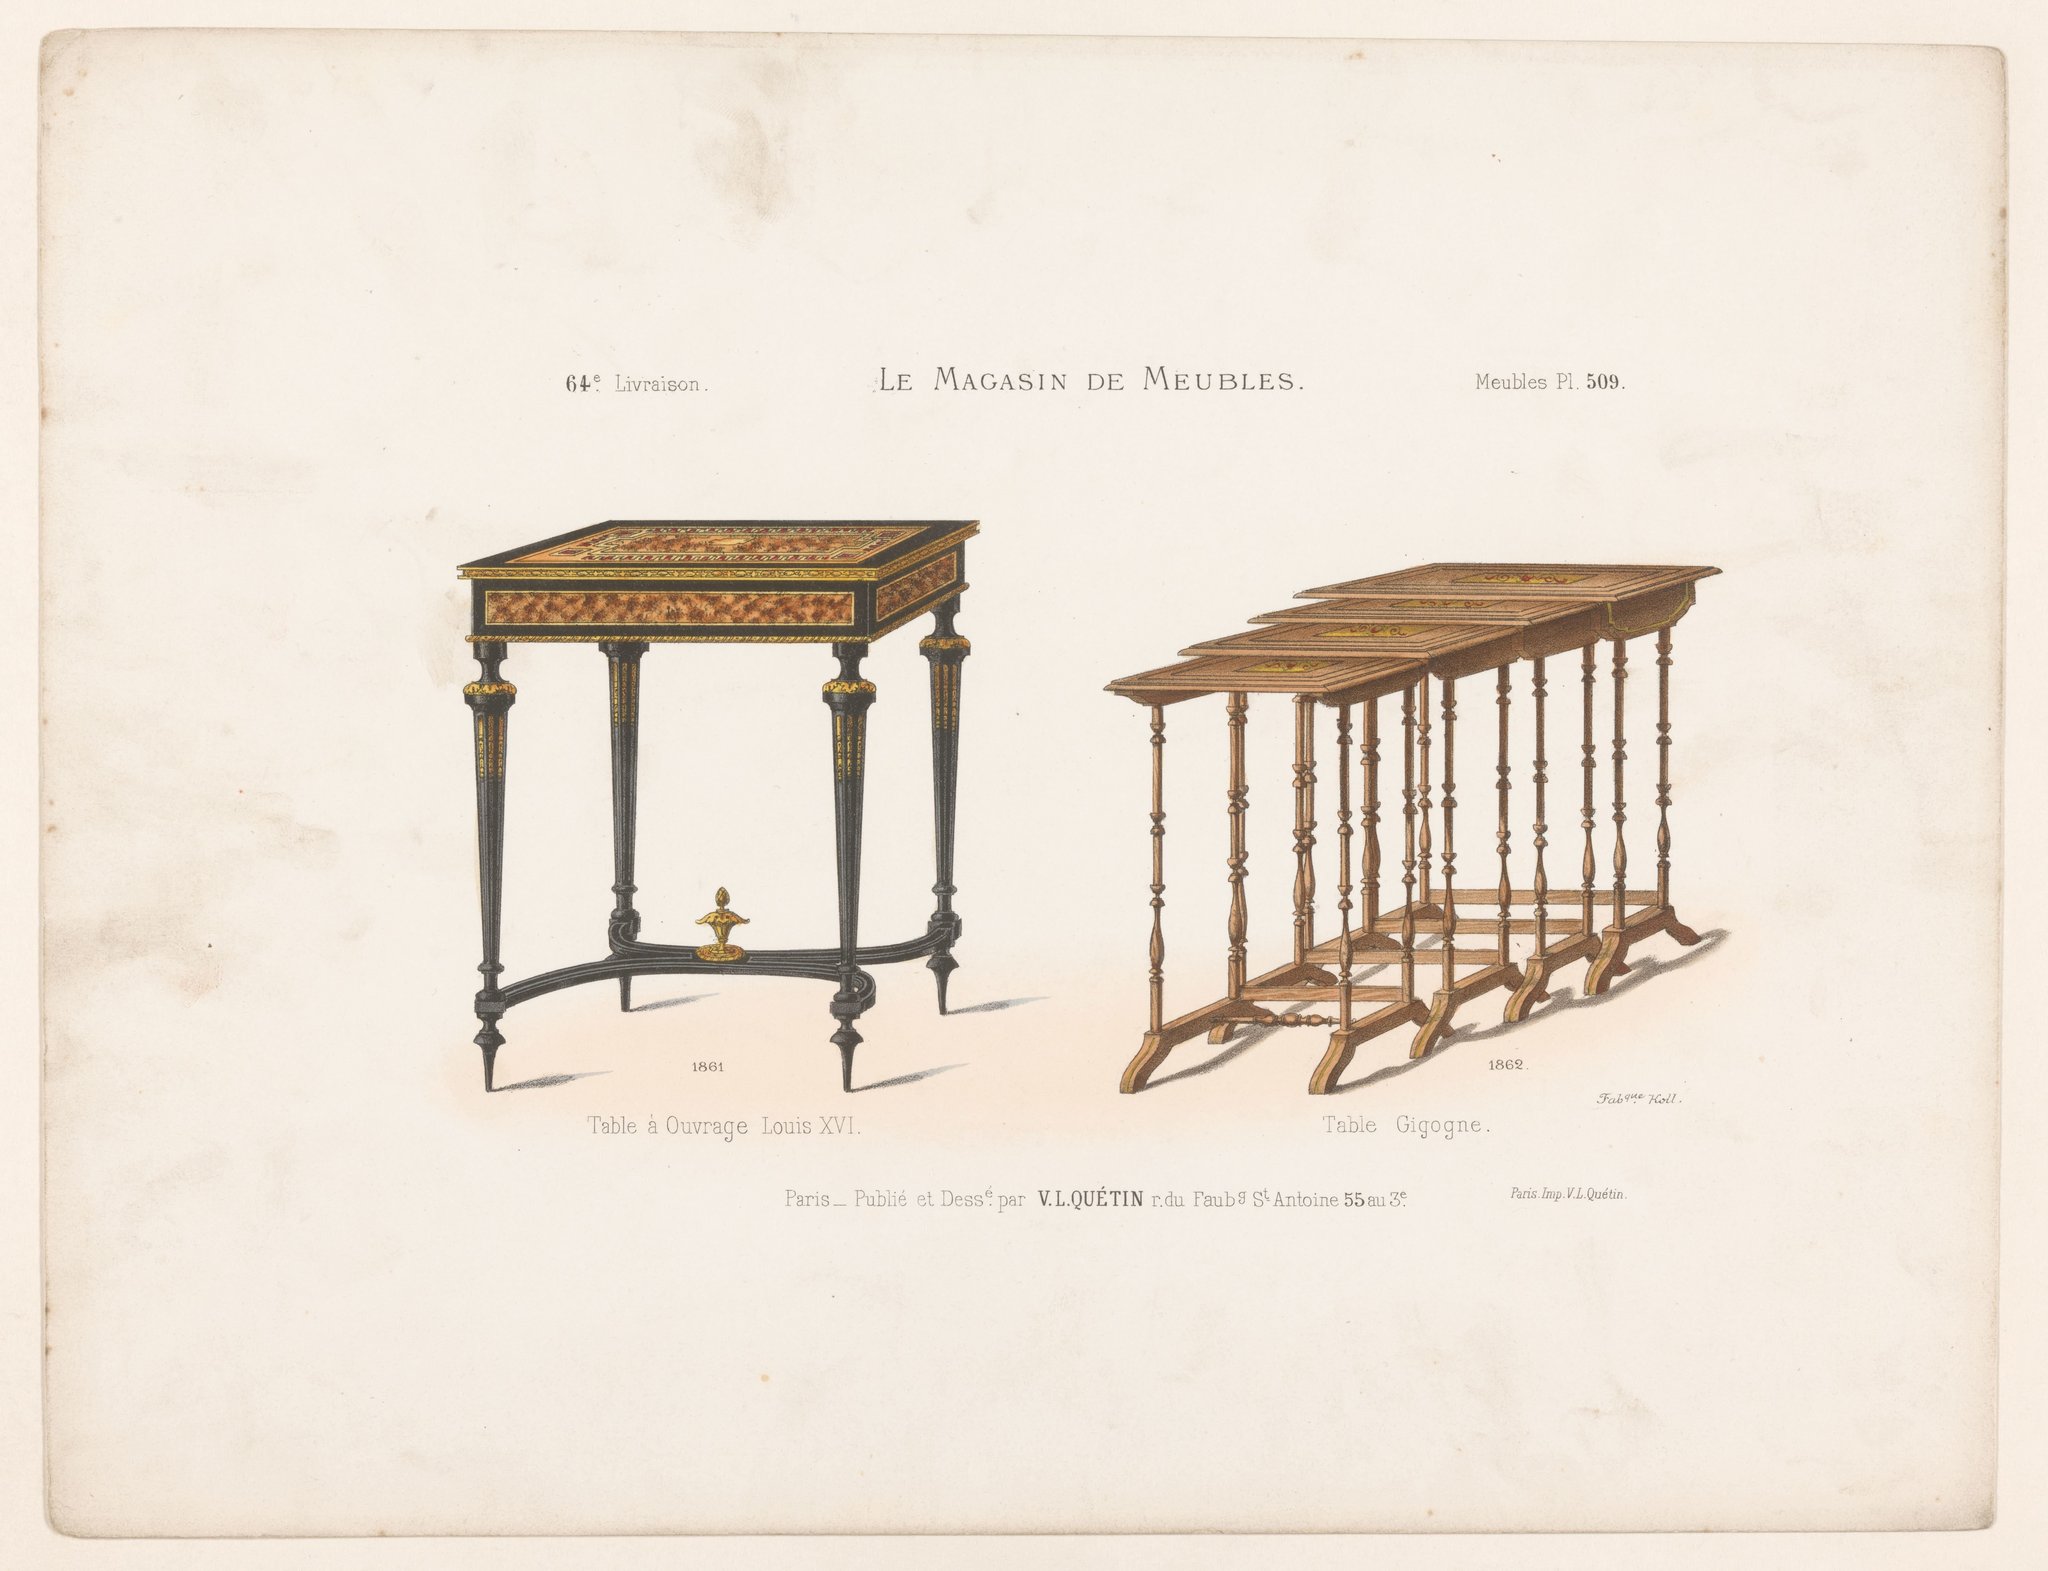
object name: print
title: Twee tafels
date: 1878-1904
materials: paper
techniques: hand coloring, lithograph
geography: paris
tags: table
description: Een tafel met opklapbaar blad en een meubel bestaand uit vier in elkaar schuivende tafels. Prent uit 64e Livraison.